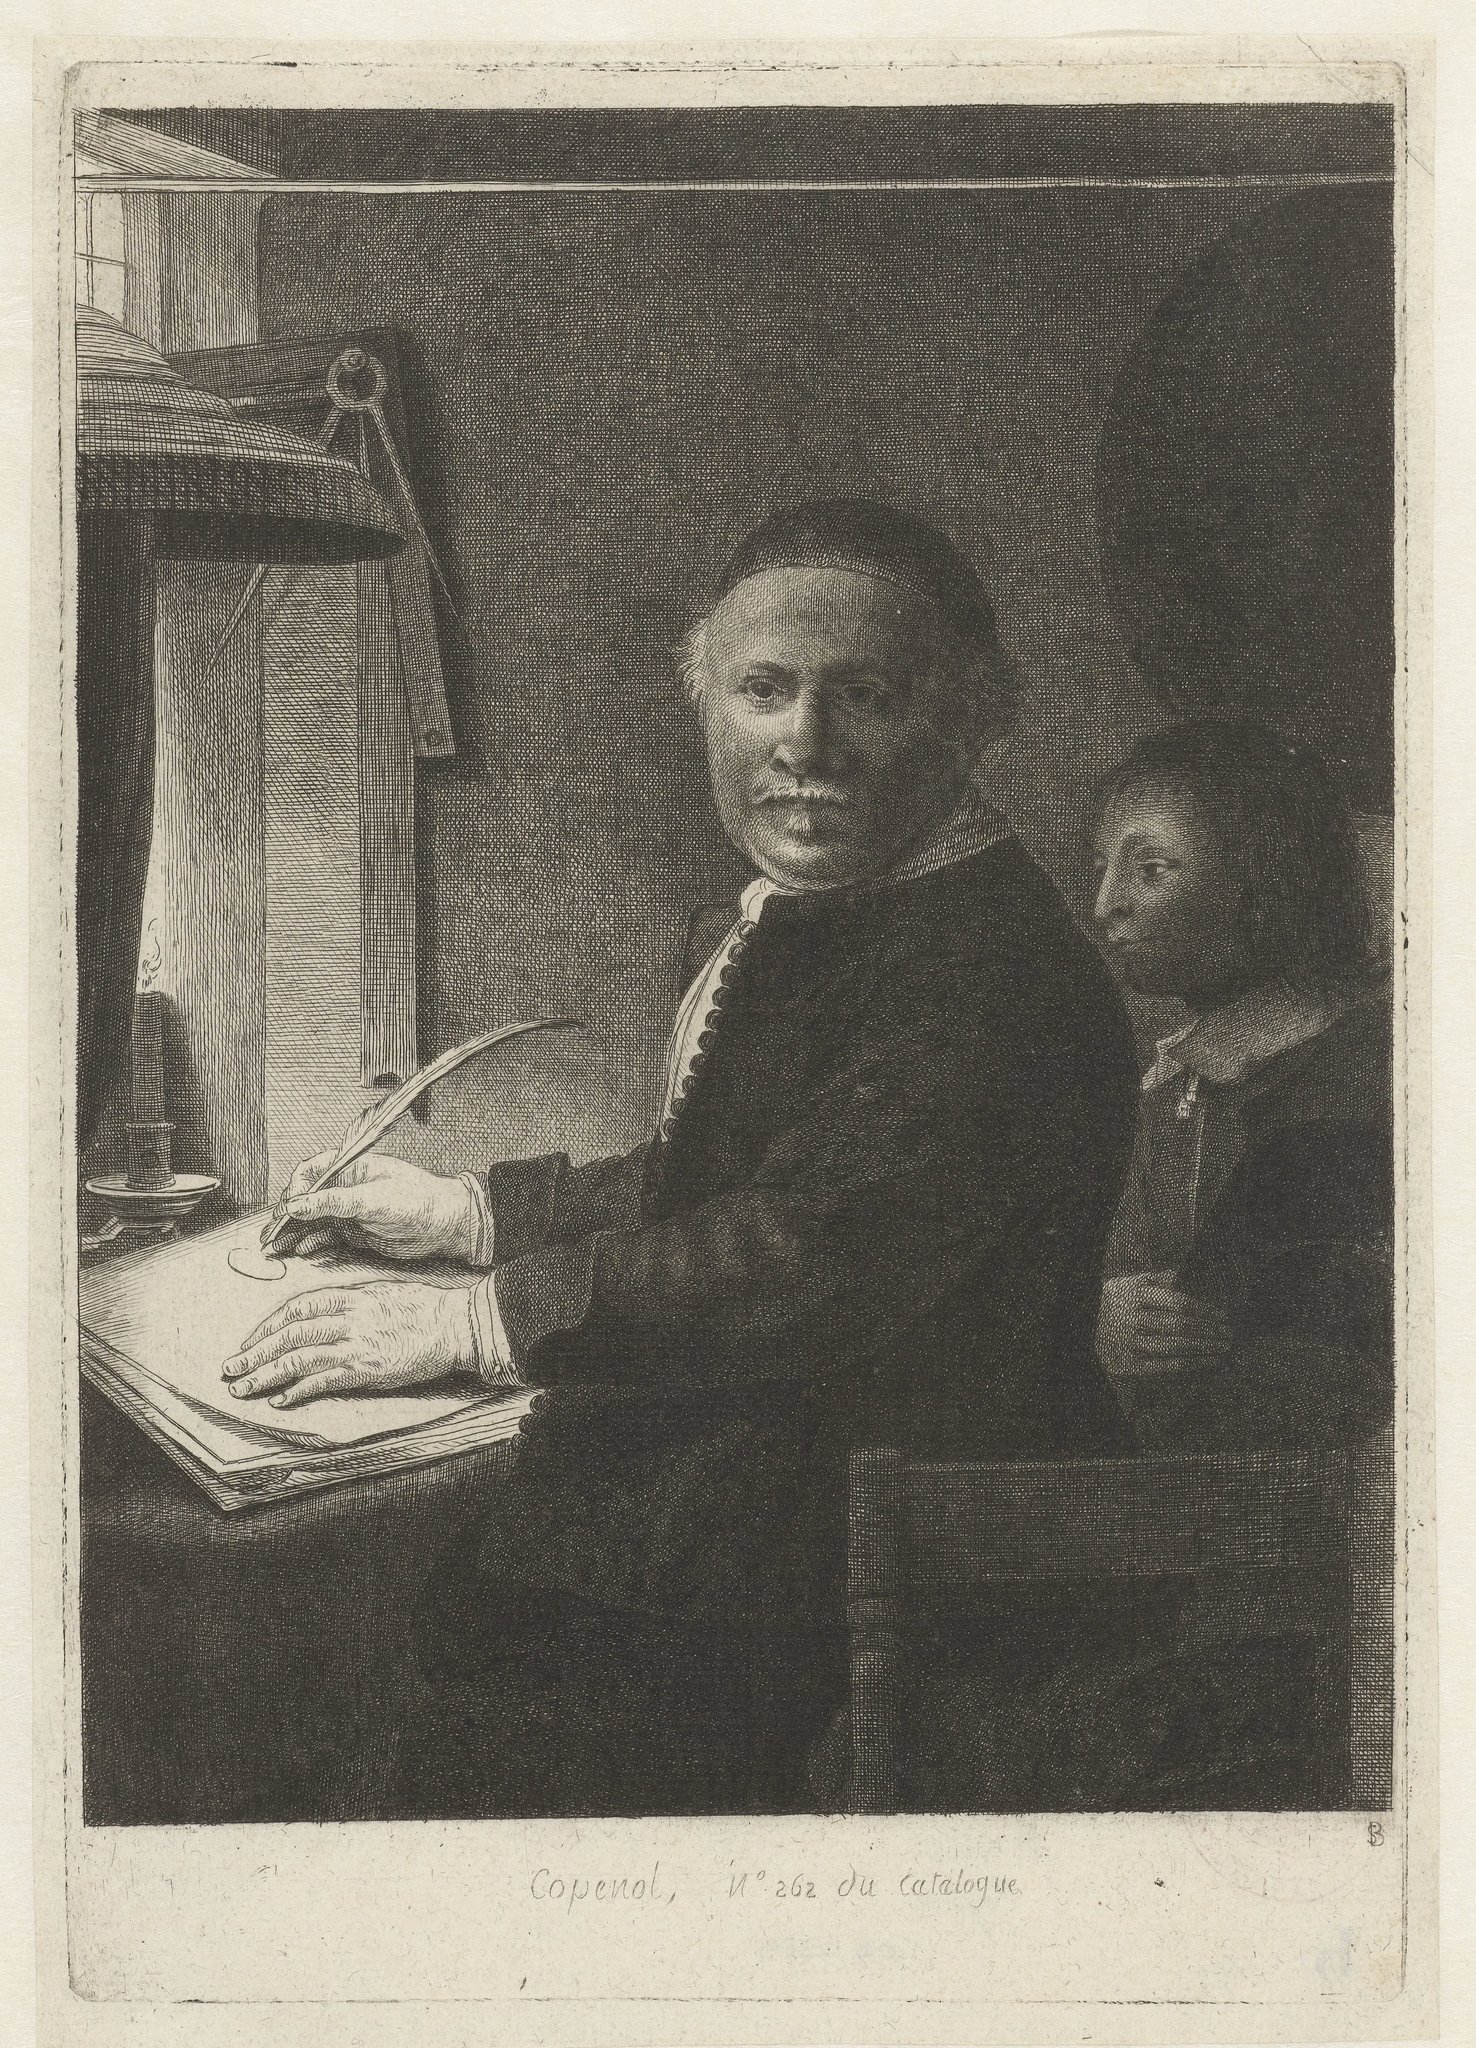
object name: print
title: Lieven Willemsz. van Coppenol, writing master: the smaller plate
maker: pierre françois basan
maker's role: print maker, publisher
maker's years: 1723-1797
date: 1733-1797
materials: paper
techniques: etching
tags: lieven willemsz. coppenol, historical persons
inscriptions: collector's mark: Lugt 240